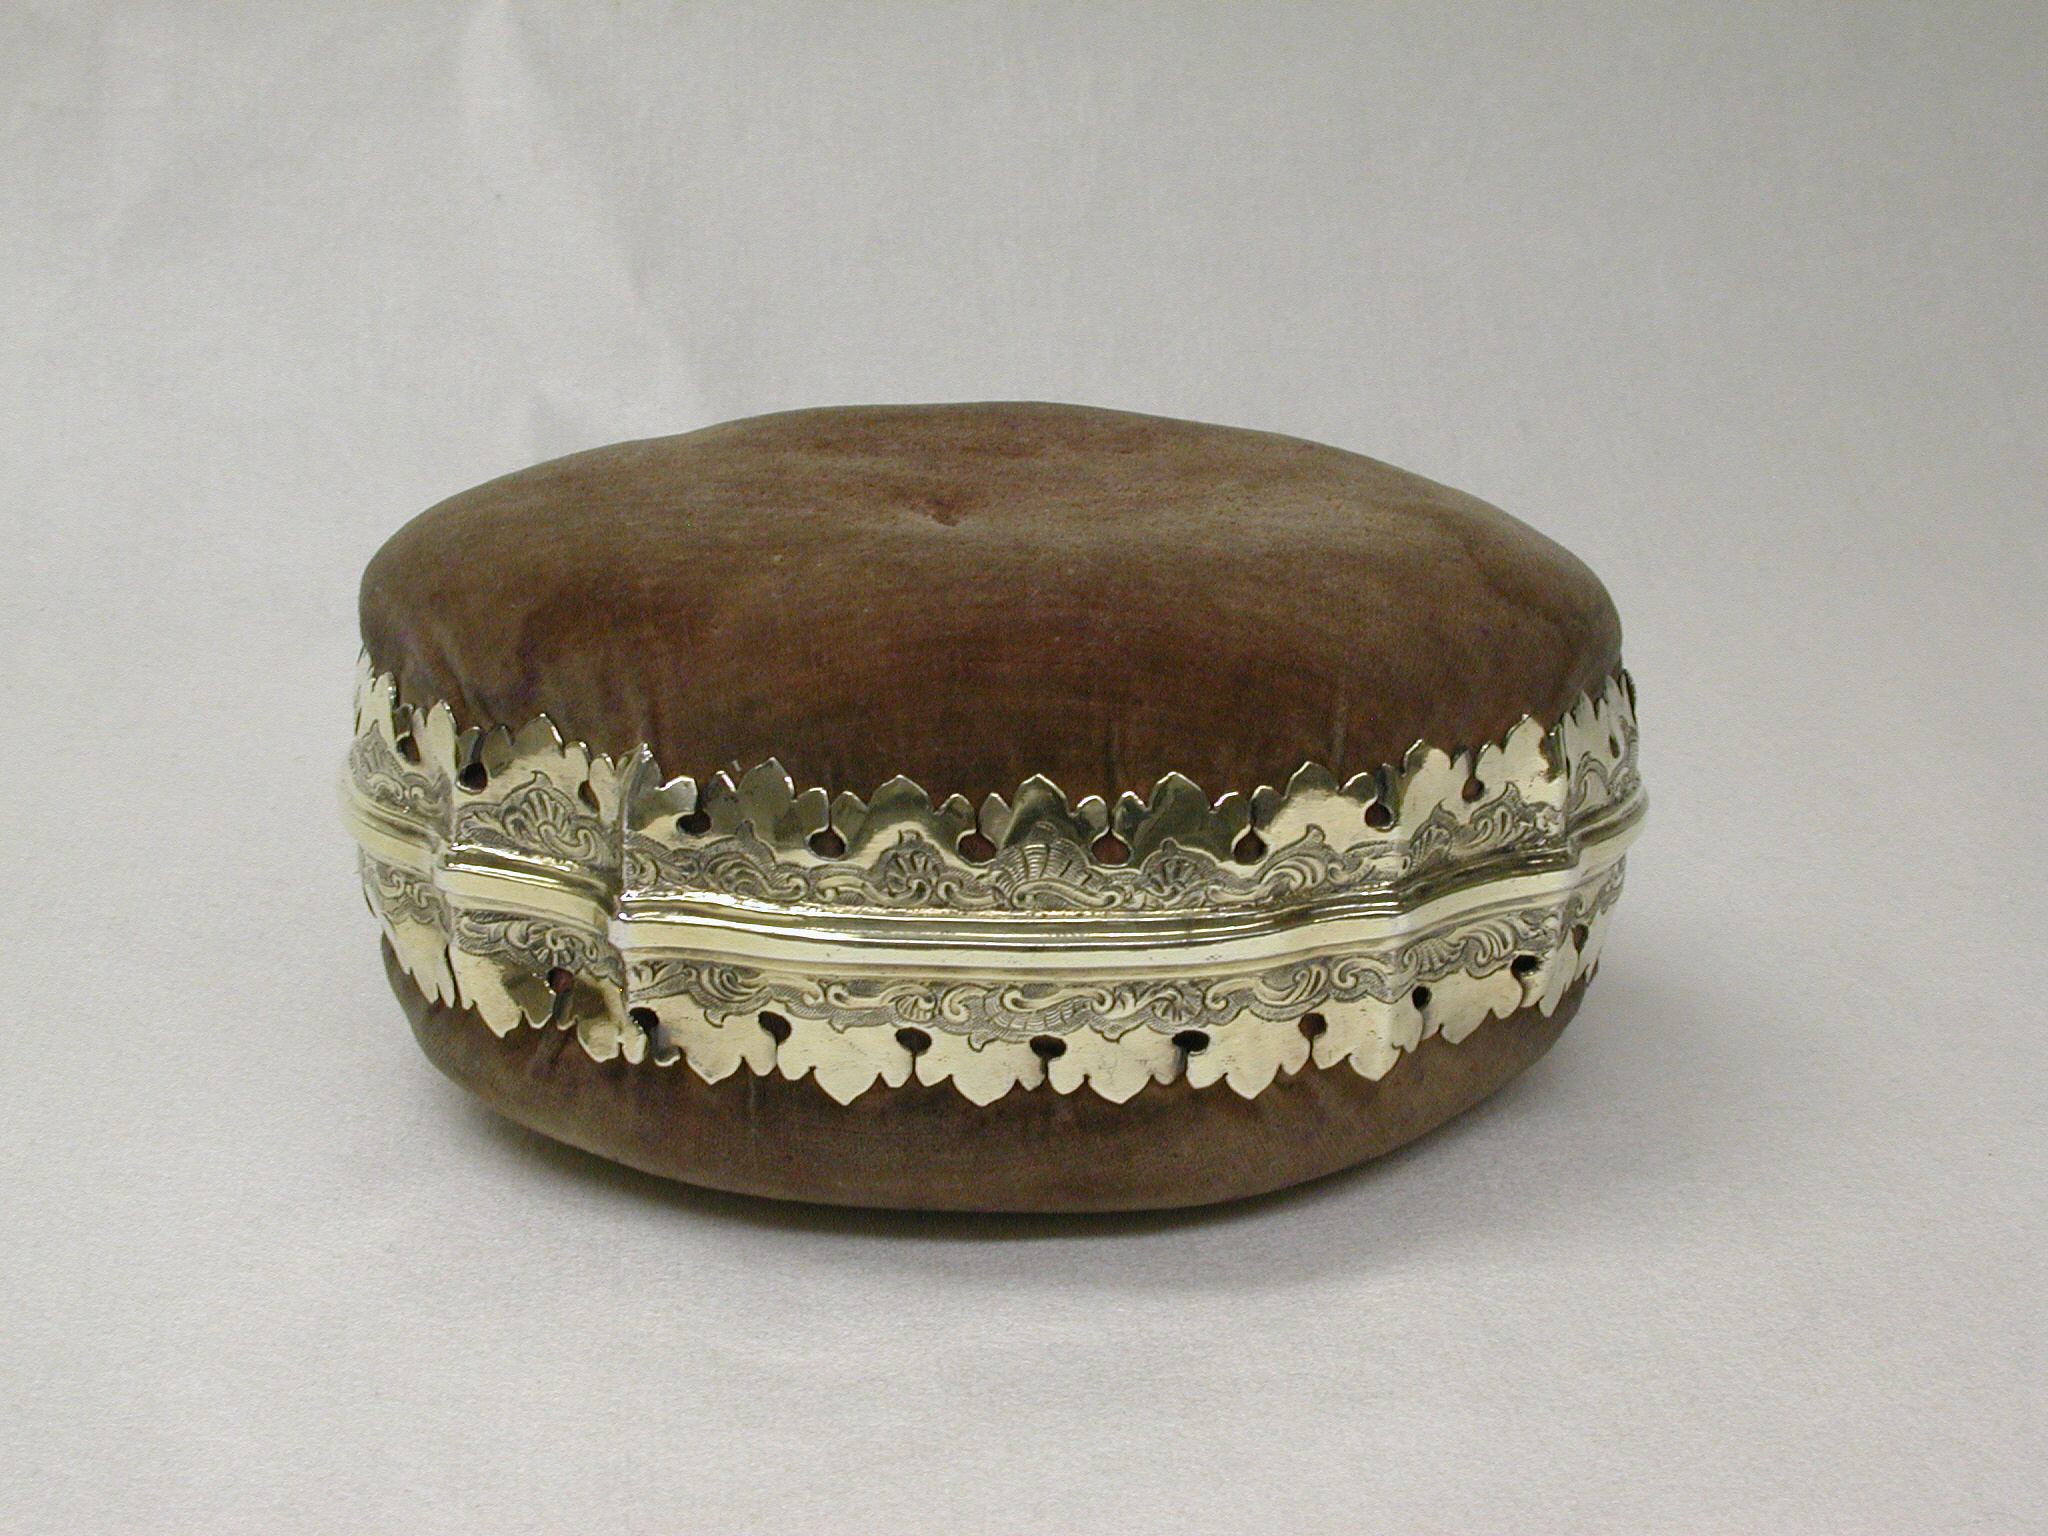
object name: pincushion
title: Pin cushion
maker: johann jakob schoap i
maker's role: maker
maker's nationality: german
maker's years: 1725-1774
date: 1743-1745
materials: silver gilt